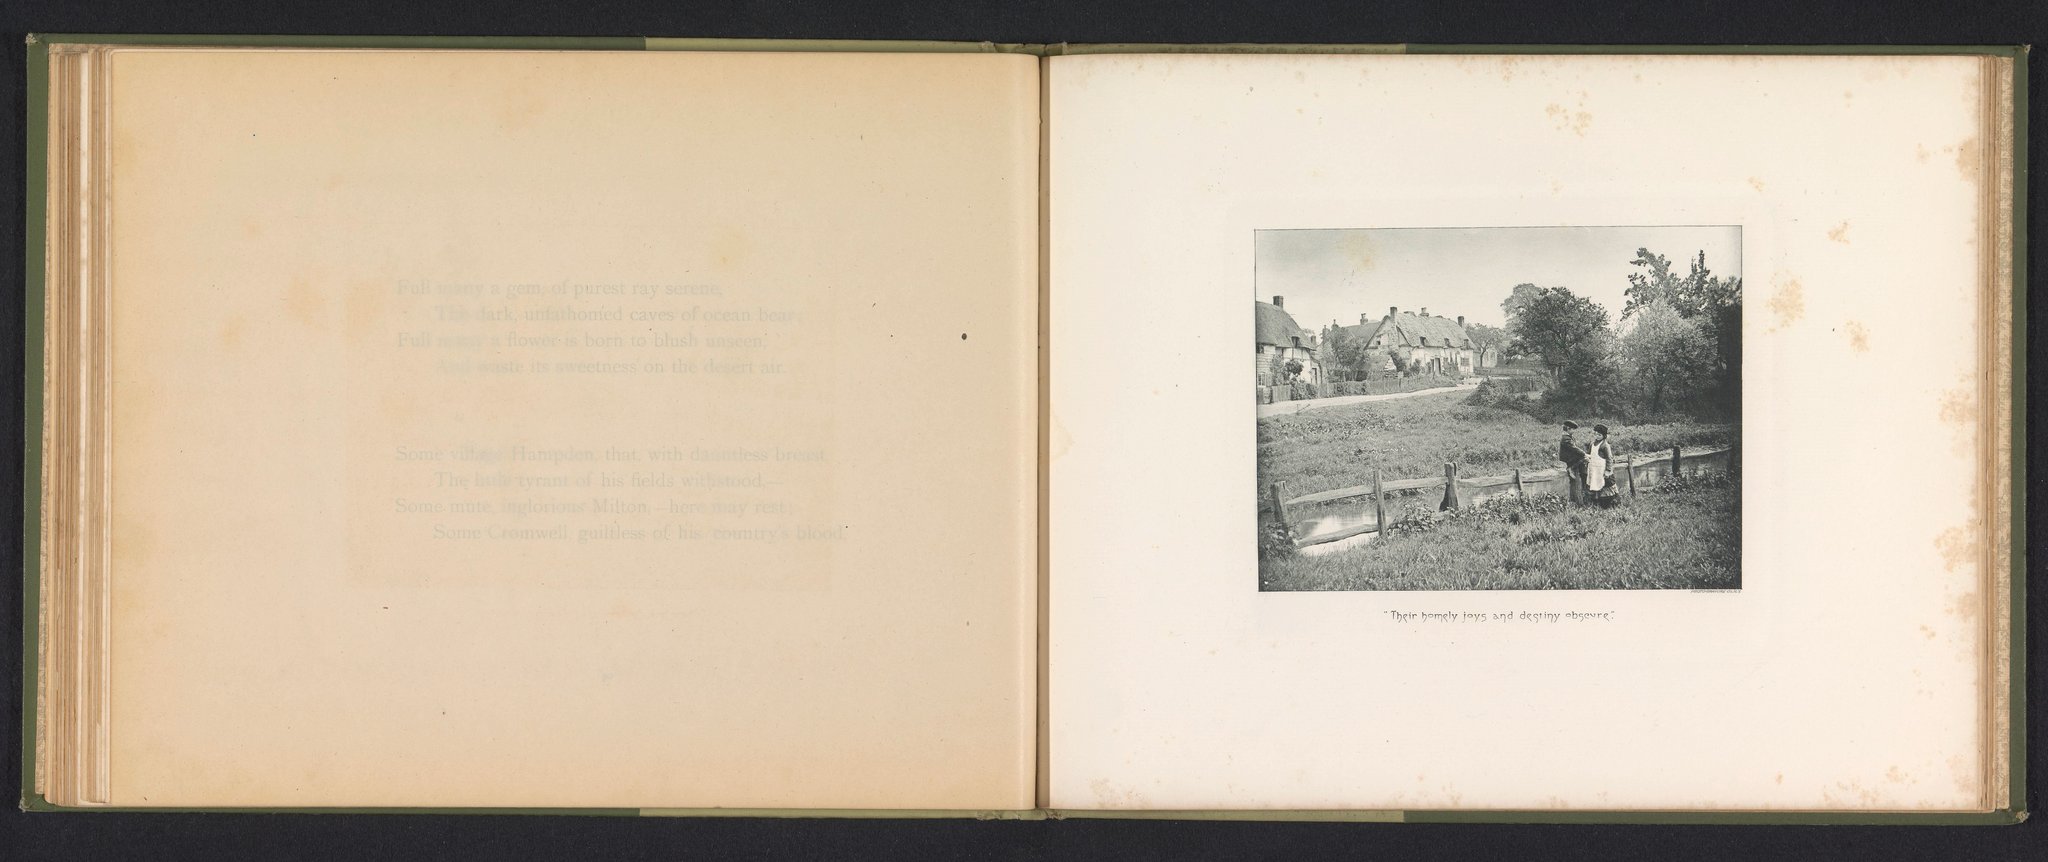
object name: photomechanical print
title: Gezicht op een jongen en een meisje op een hek in een grasland voor huizen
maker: james leon williams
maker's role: fotograaf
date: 1881-1891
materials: paper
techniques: photoaquatint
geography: england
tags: fence, wall, paling, village, england